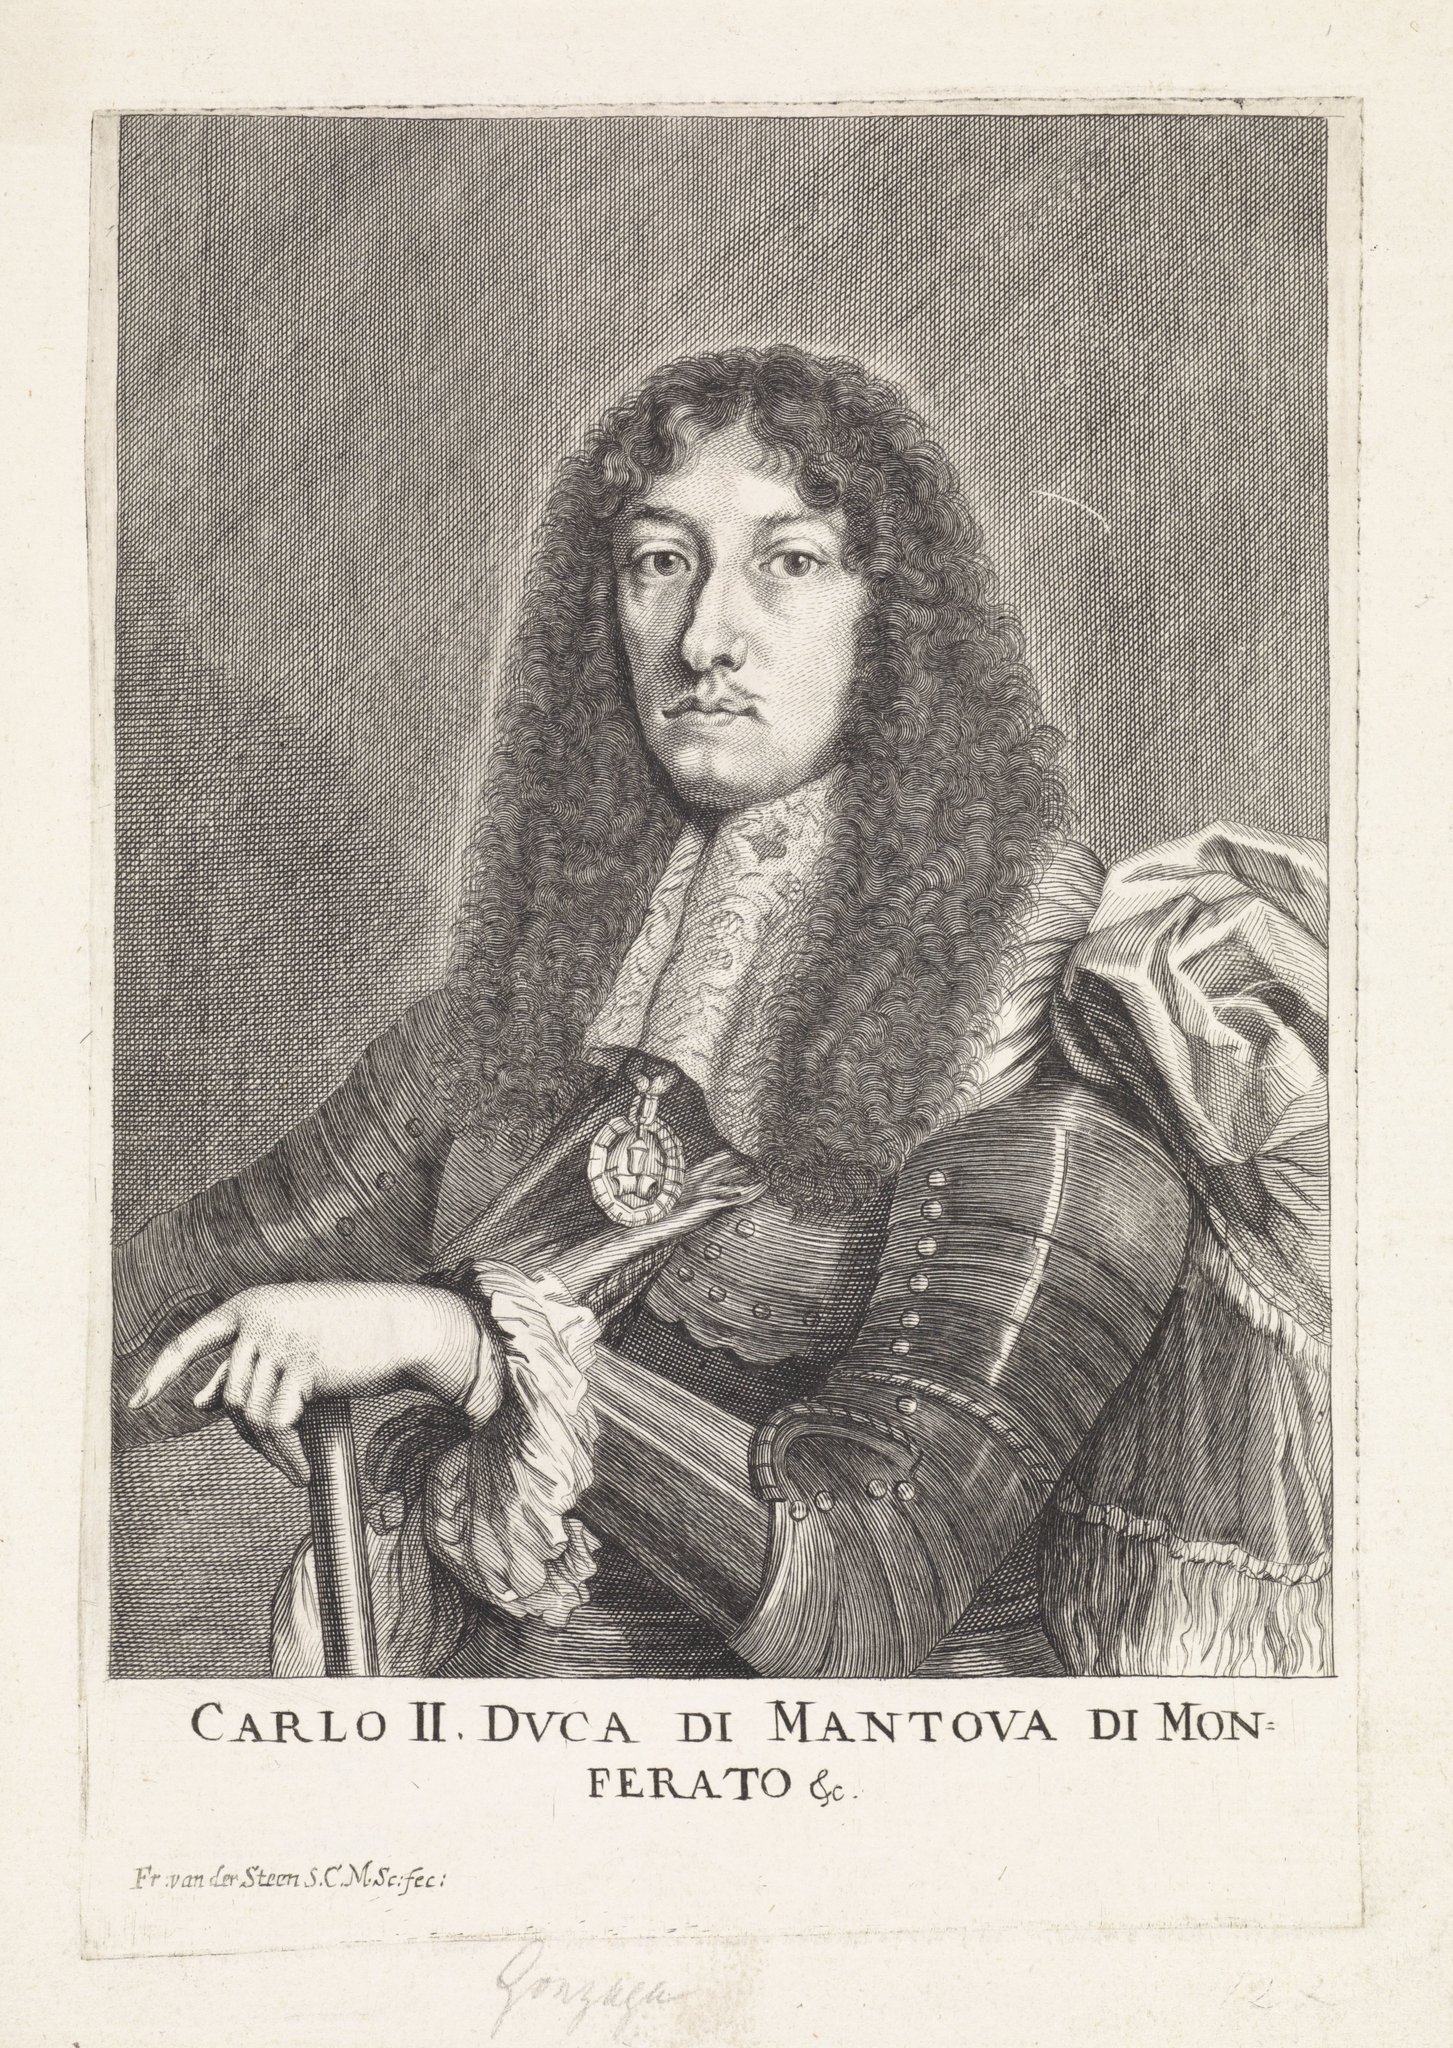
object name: print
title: Portret van Carlo II Gonzaga, hertog van Mantua en Montferrat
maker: frans van der steen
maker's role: print maker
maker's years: 1625-1672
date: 1657-1672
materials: paper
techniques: engraving, etching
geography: vienna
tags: carlo ii gonzaga (hertog van mantua en montferrat)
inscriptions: collector's mark: Lugt 2228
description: Portret van Carlo II Gonzaga, hertog van Mantua en Montferrat, in harnas en met zijn hand op een staf.